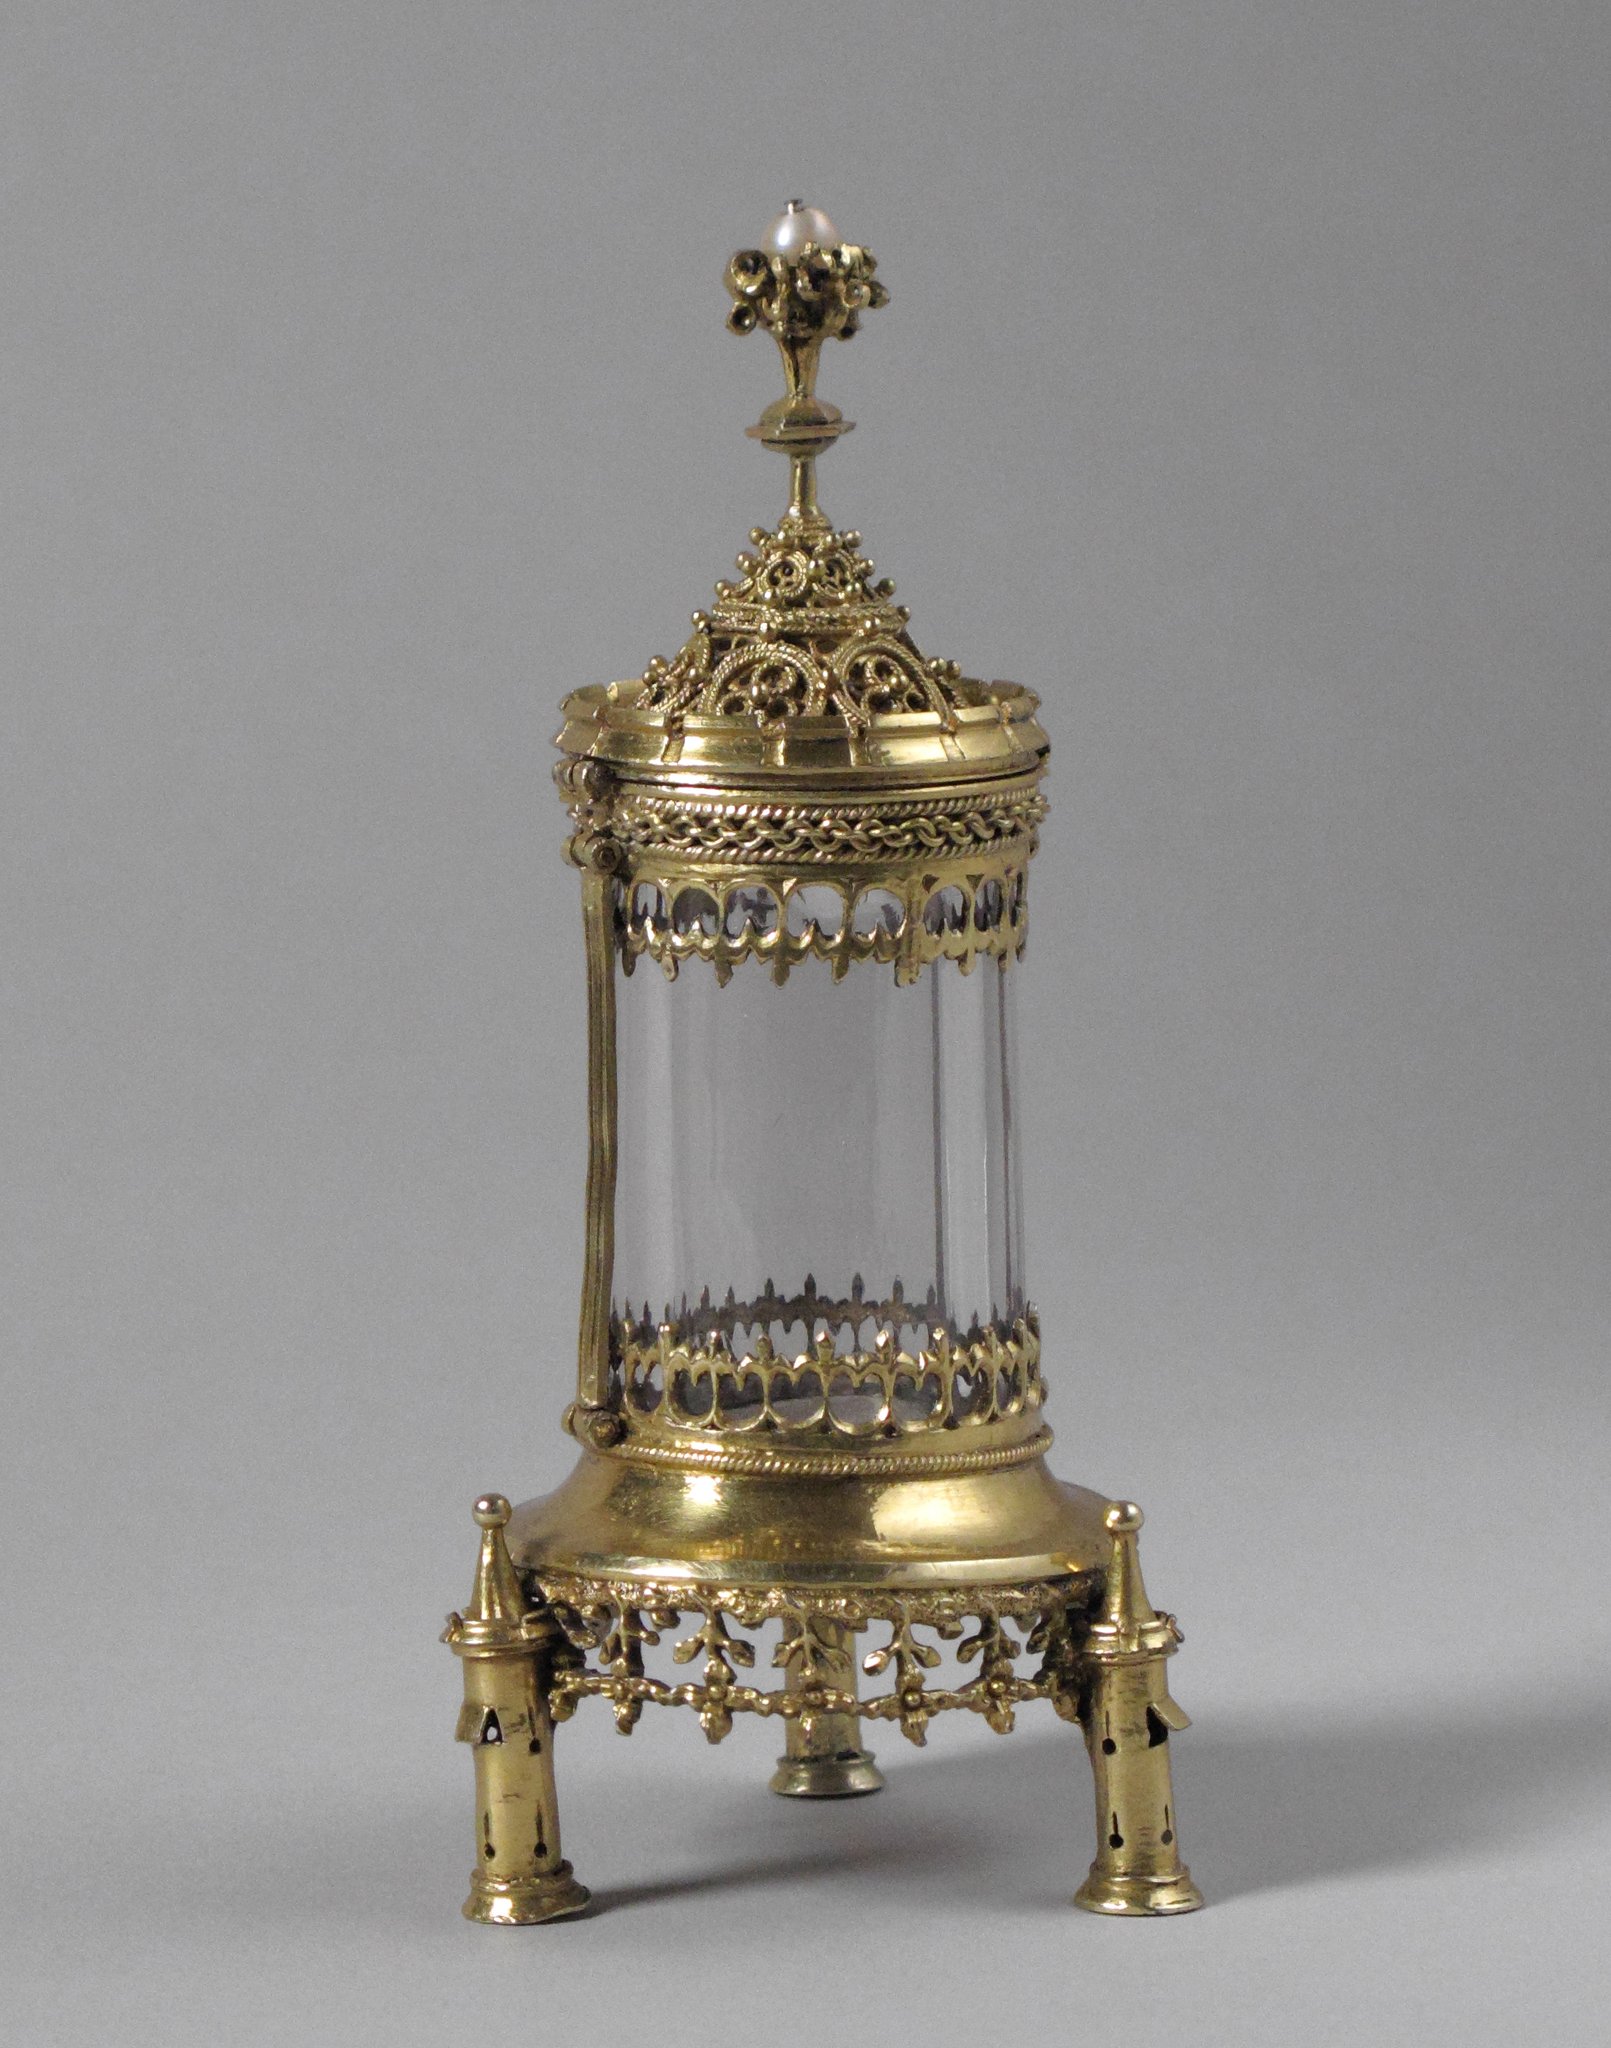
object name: reliquary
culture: hungarian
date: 1500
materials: pearl, quartz, silver gilt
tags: reliquaries